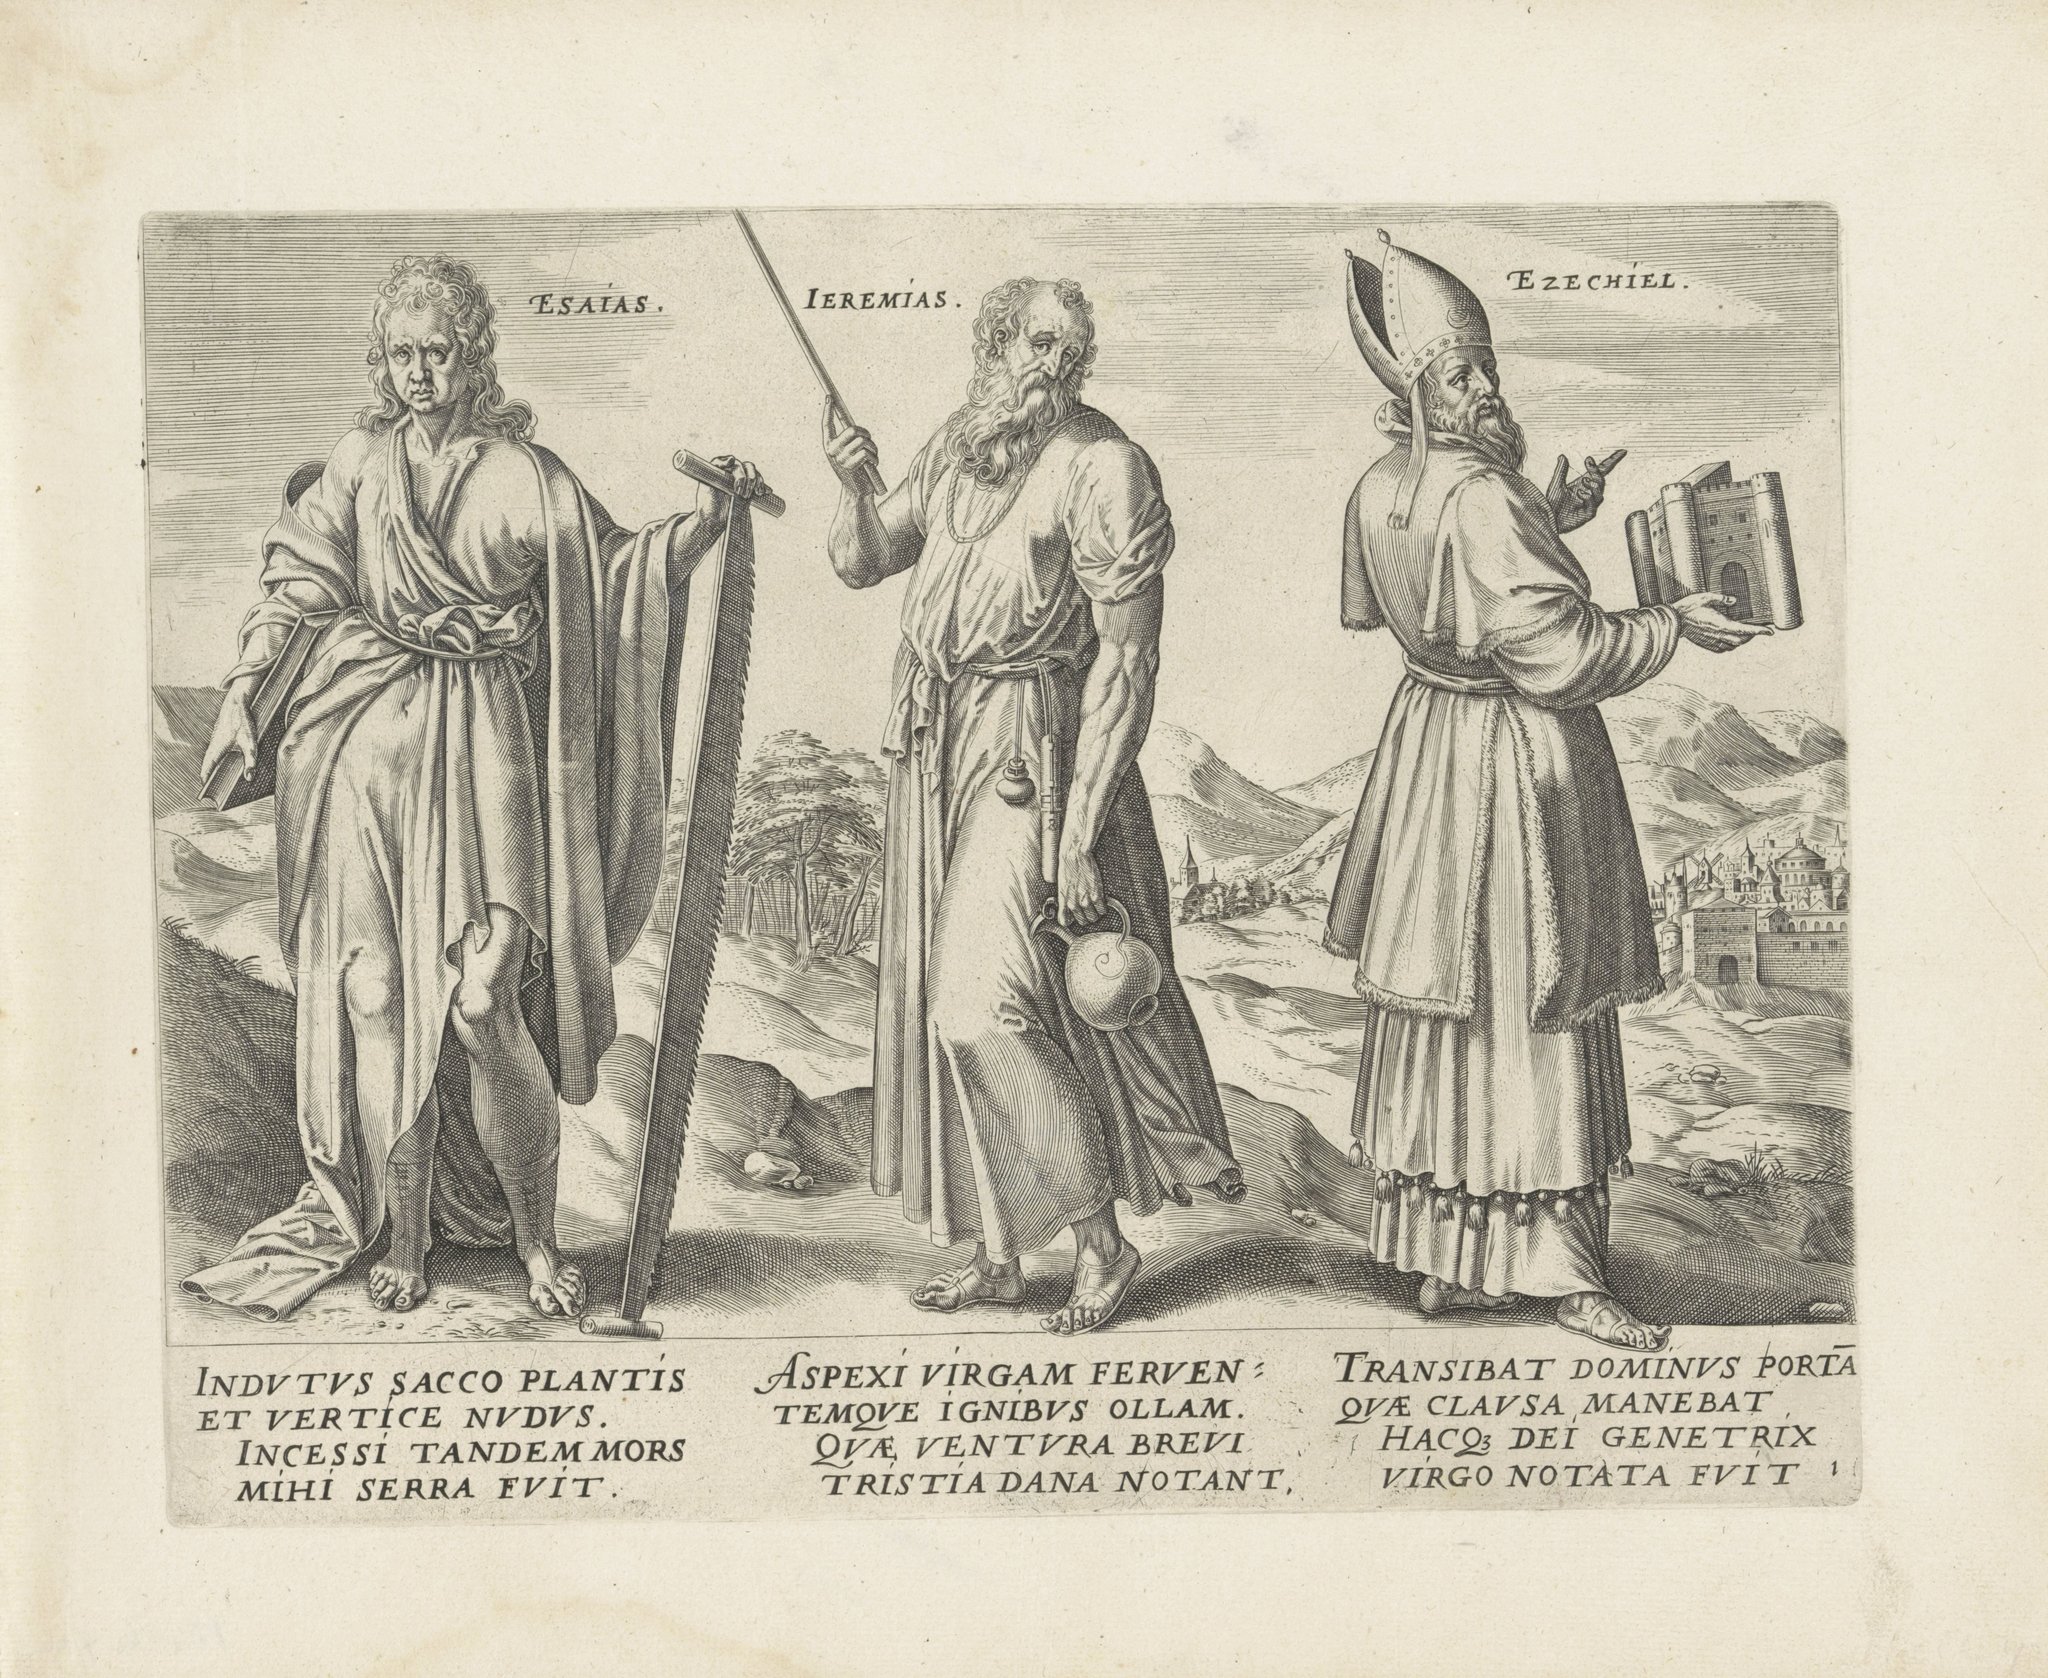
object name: print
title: Twaalf profeten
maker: Anonymous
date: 1579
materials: paper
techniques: engraving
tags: the four major prophets (not in biblical context): isaiah, jeremiah, ezekiel, daniel, jeremiah (not in biblical context); possible attributes: book or scroll, 'the seething pot', isaiah (not in biblical context); possible attributes: branch with leaves, saw, scroll or book, ezekiel (not in biblical context); possible attributes: book or scroll, double wheel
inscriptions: collector's mark: Lugt 2228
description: Eerdere staat van prent gebruikt in: Thesaurus sacrarum historiaru[m] veteris (et novi) testame[n]ti, elega[n]tissimis imaginibus expressu[m] excelle[n]tissimoru[m] in hac arte viroru[m] opera : nu[n]c primu[m] in luce[m] editus. Antwerpen: Gerard de Jode, 1585. Latere staat van prent gebruikt in: Theatrum biblicum : hoc est historiae sacrae veteris et novi testamenti tabulis aeneis expressae. Opus praesentatissimorum huius ac superioris seculi pictorum atque sculptorum, summo studio conquisitum et in lucem editum. Amsterdam: Claes Jansz. Visscher, 1643.